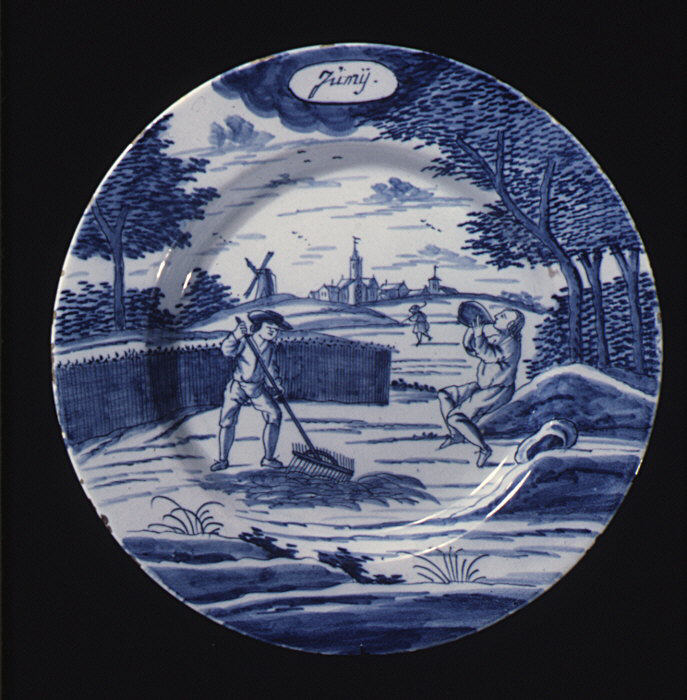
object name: plate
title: Plate (part of a set)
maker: de porceleyne bijl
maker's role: maker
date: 1764-1788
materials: earthenware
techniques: glazing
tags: men,trees,working